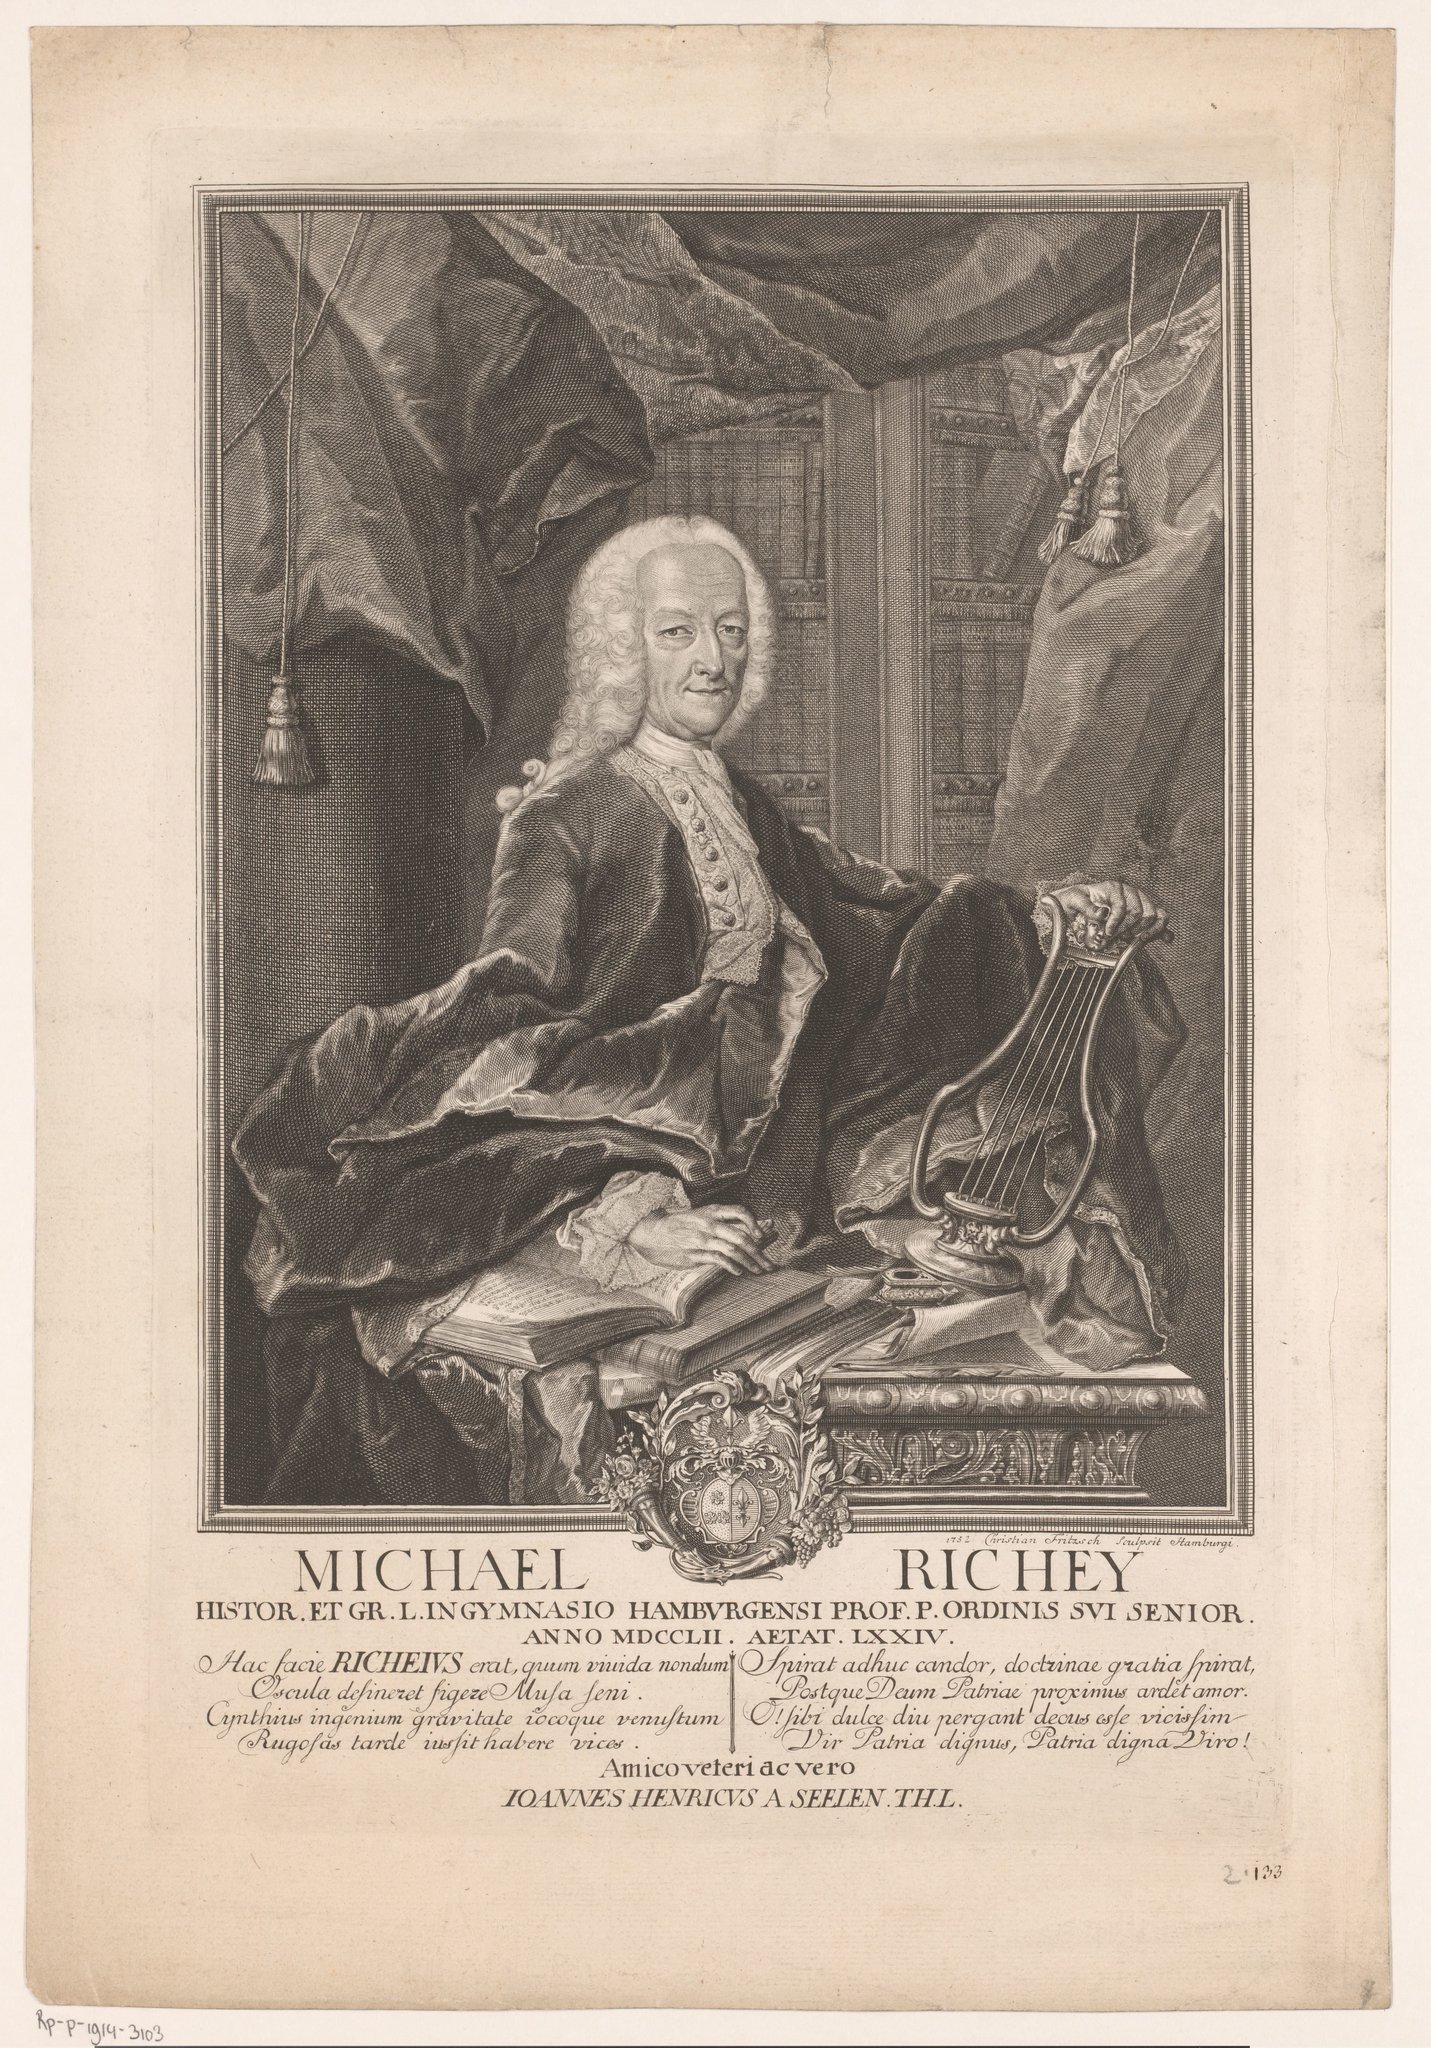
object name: print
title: Portret van Michael Richey op 74-jarige leeftijd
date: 1752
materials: paper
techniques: engraving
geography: hamburg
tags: bookshelves, lyre, cithara, psaltery, historical persons, book, writer, poet, author, armorial bearing, heraldry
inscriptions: collector's mark: Lugt 2228